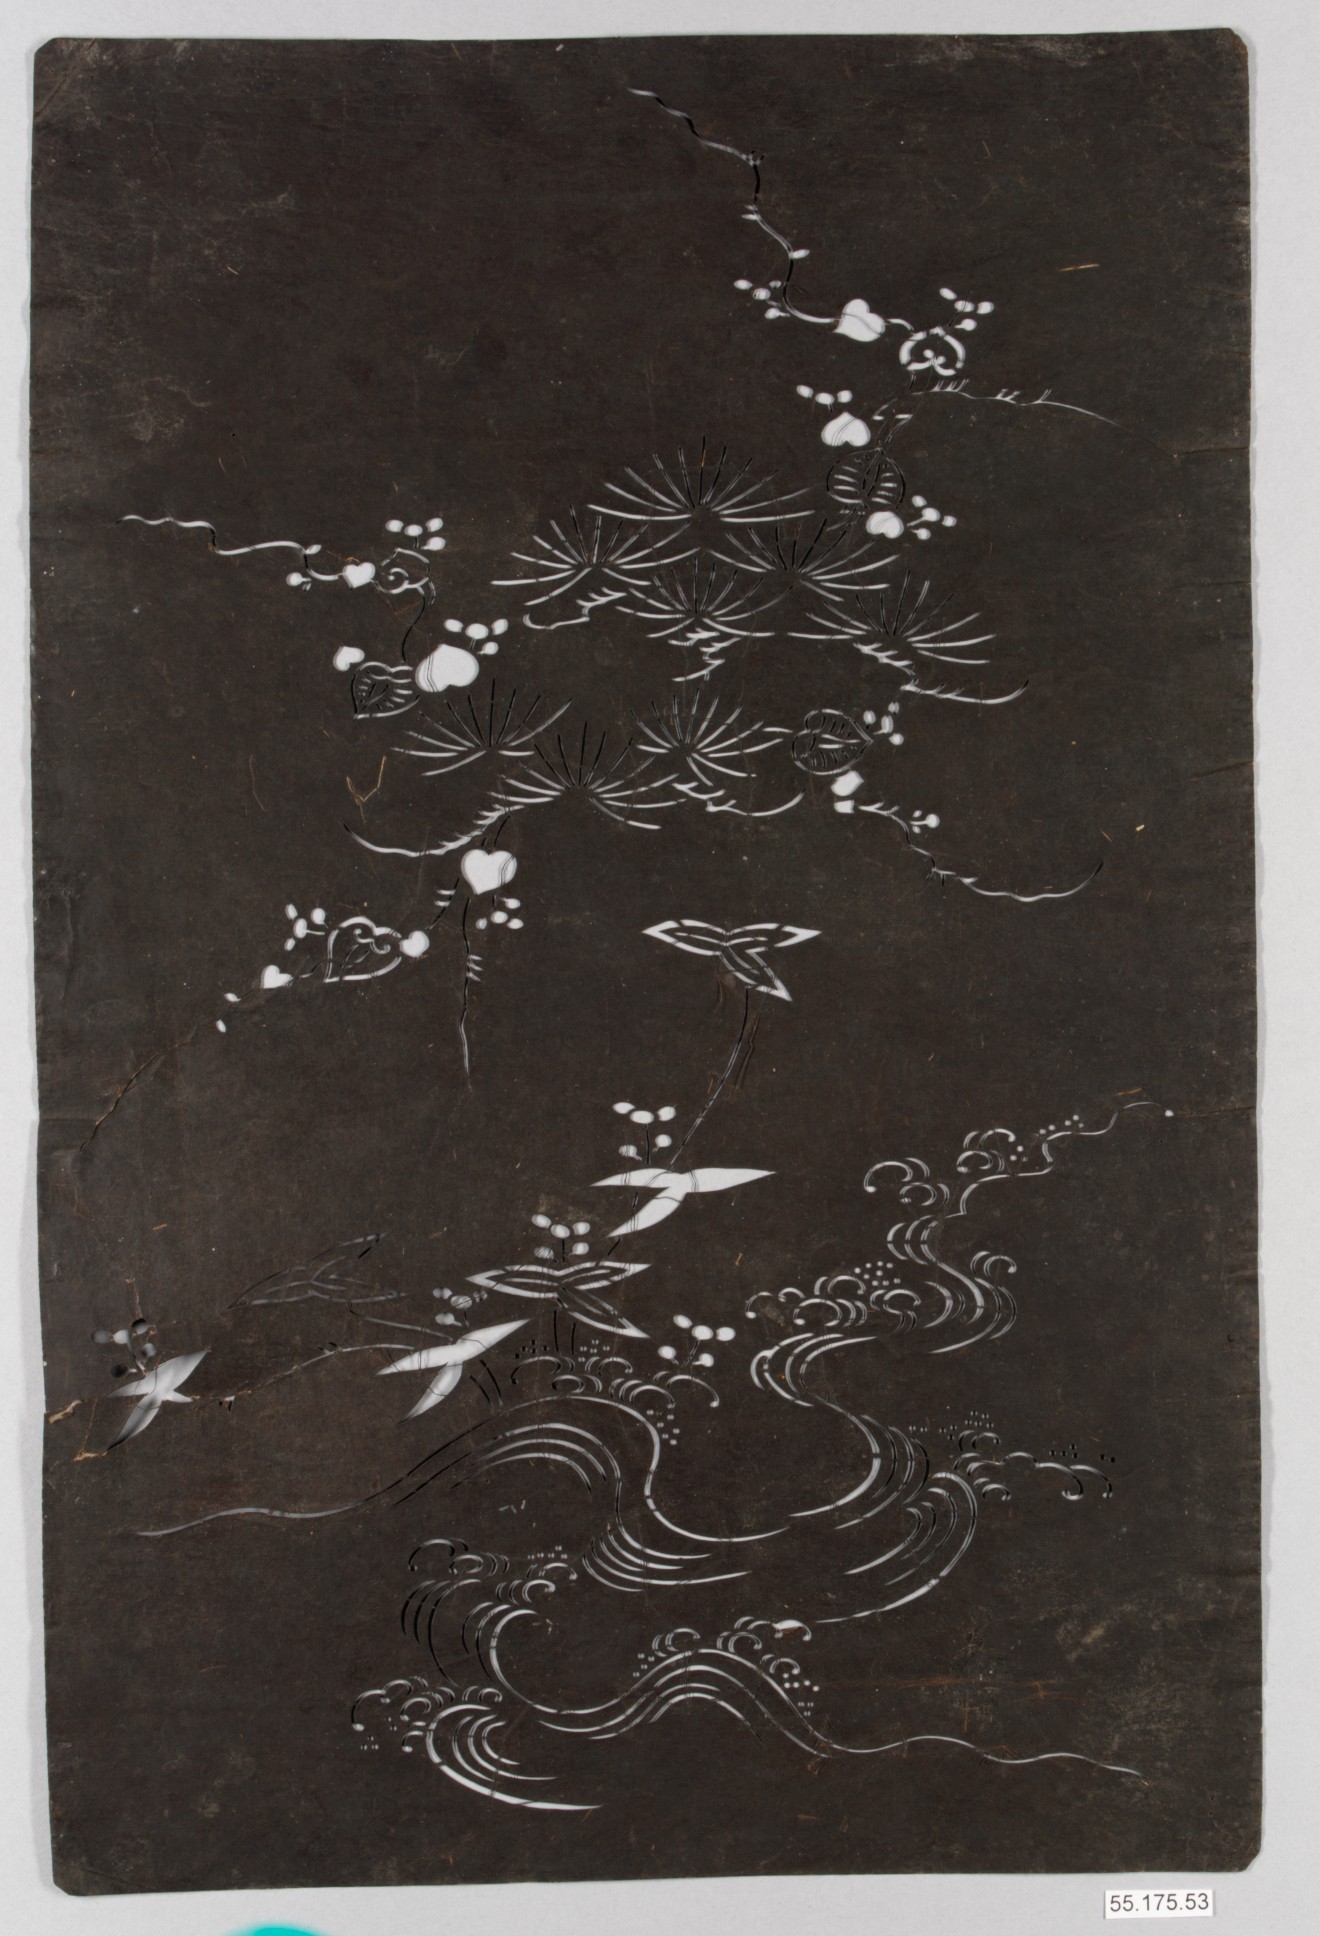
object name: stencil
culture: japanese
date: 1801-1900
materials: paper